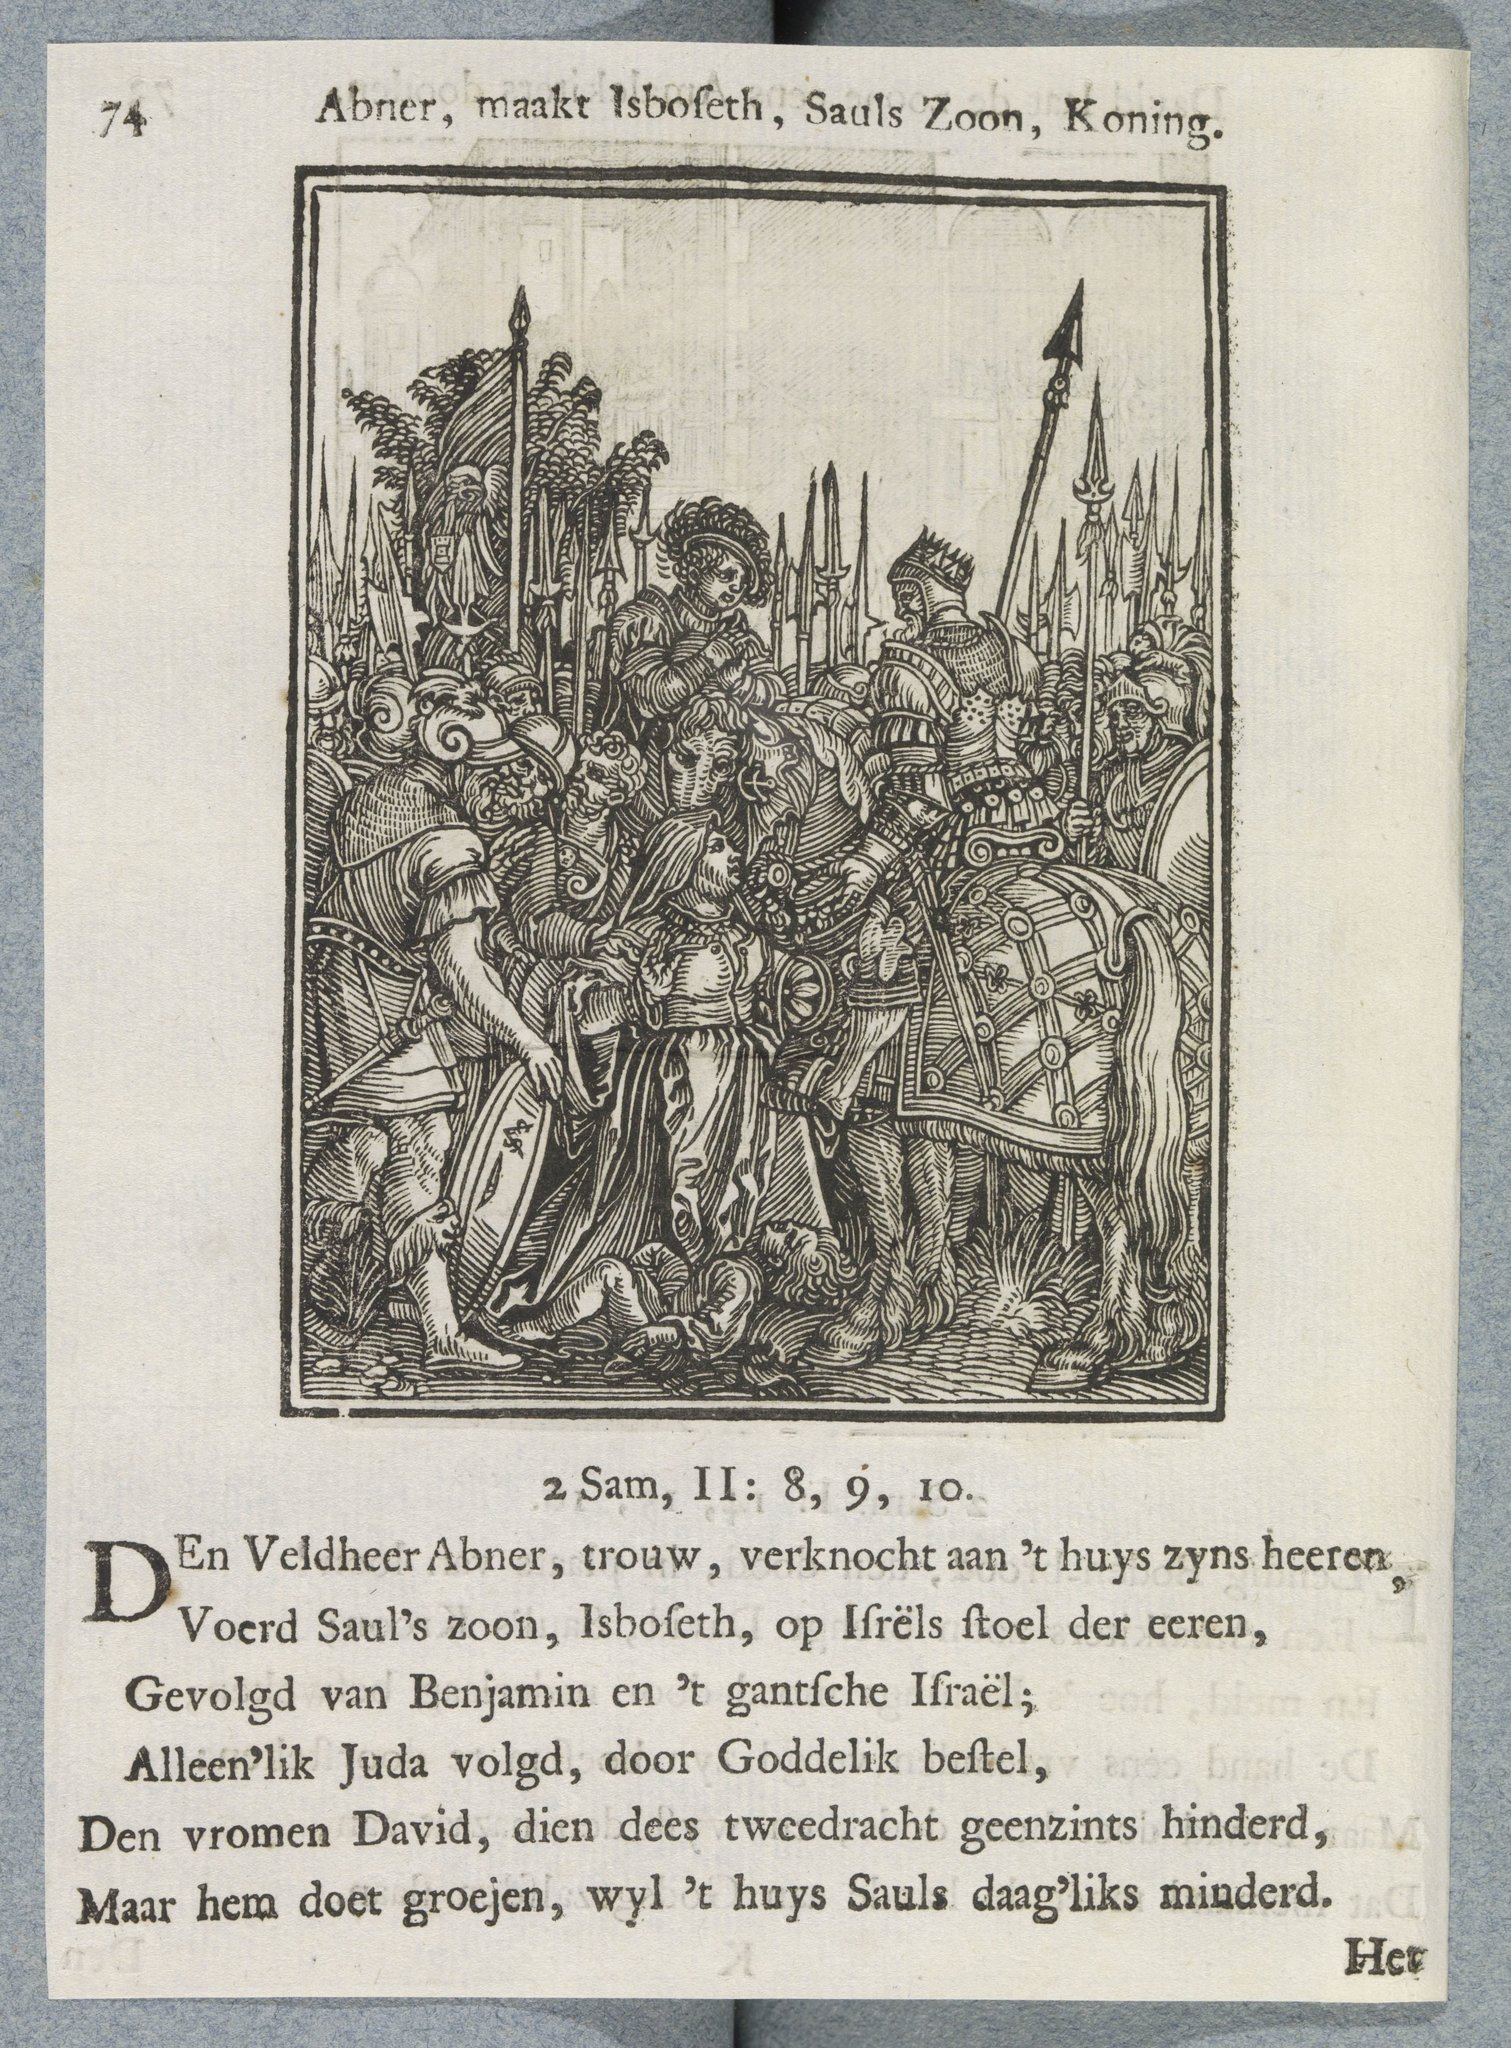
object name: print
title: Abner maakt Isboset koning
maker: jan klooster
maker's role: bookseller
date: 1645-1646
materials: paper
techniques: letterpress printing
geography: amsterdam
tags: saul's son ish-bosheth made king of israel by abner, commander of saul's army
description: De prent is afkomstig uit: Bybels Lusthof. Amsterdam, J. Klooster, 1740. De prent werd gemaakt voor de uitgaven van P.J. Paets uit Amsterdam. Ze komt in ieder geval voor in: Bibels Tresoor ofte der zielen lusthof. Amsterdam, P.J. Paets, 1646. Mogelijk staat ze ook in: Historien ende Prophetien. [Amsterdam], P.J. Paets, 1645.